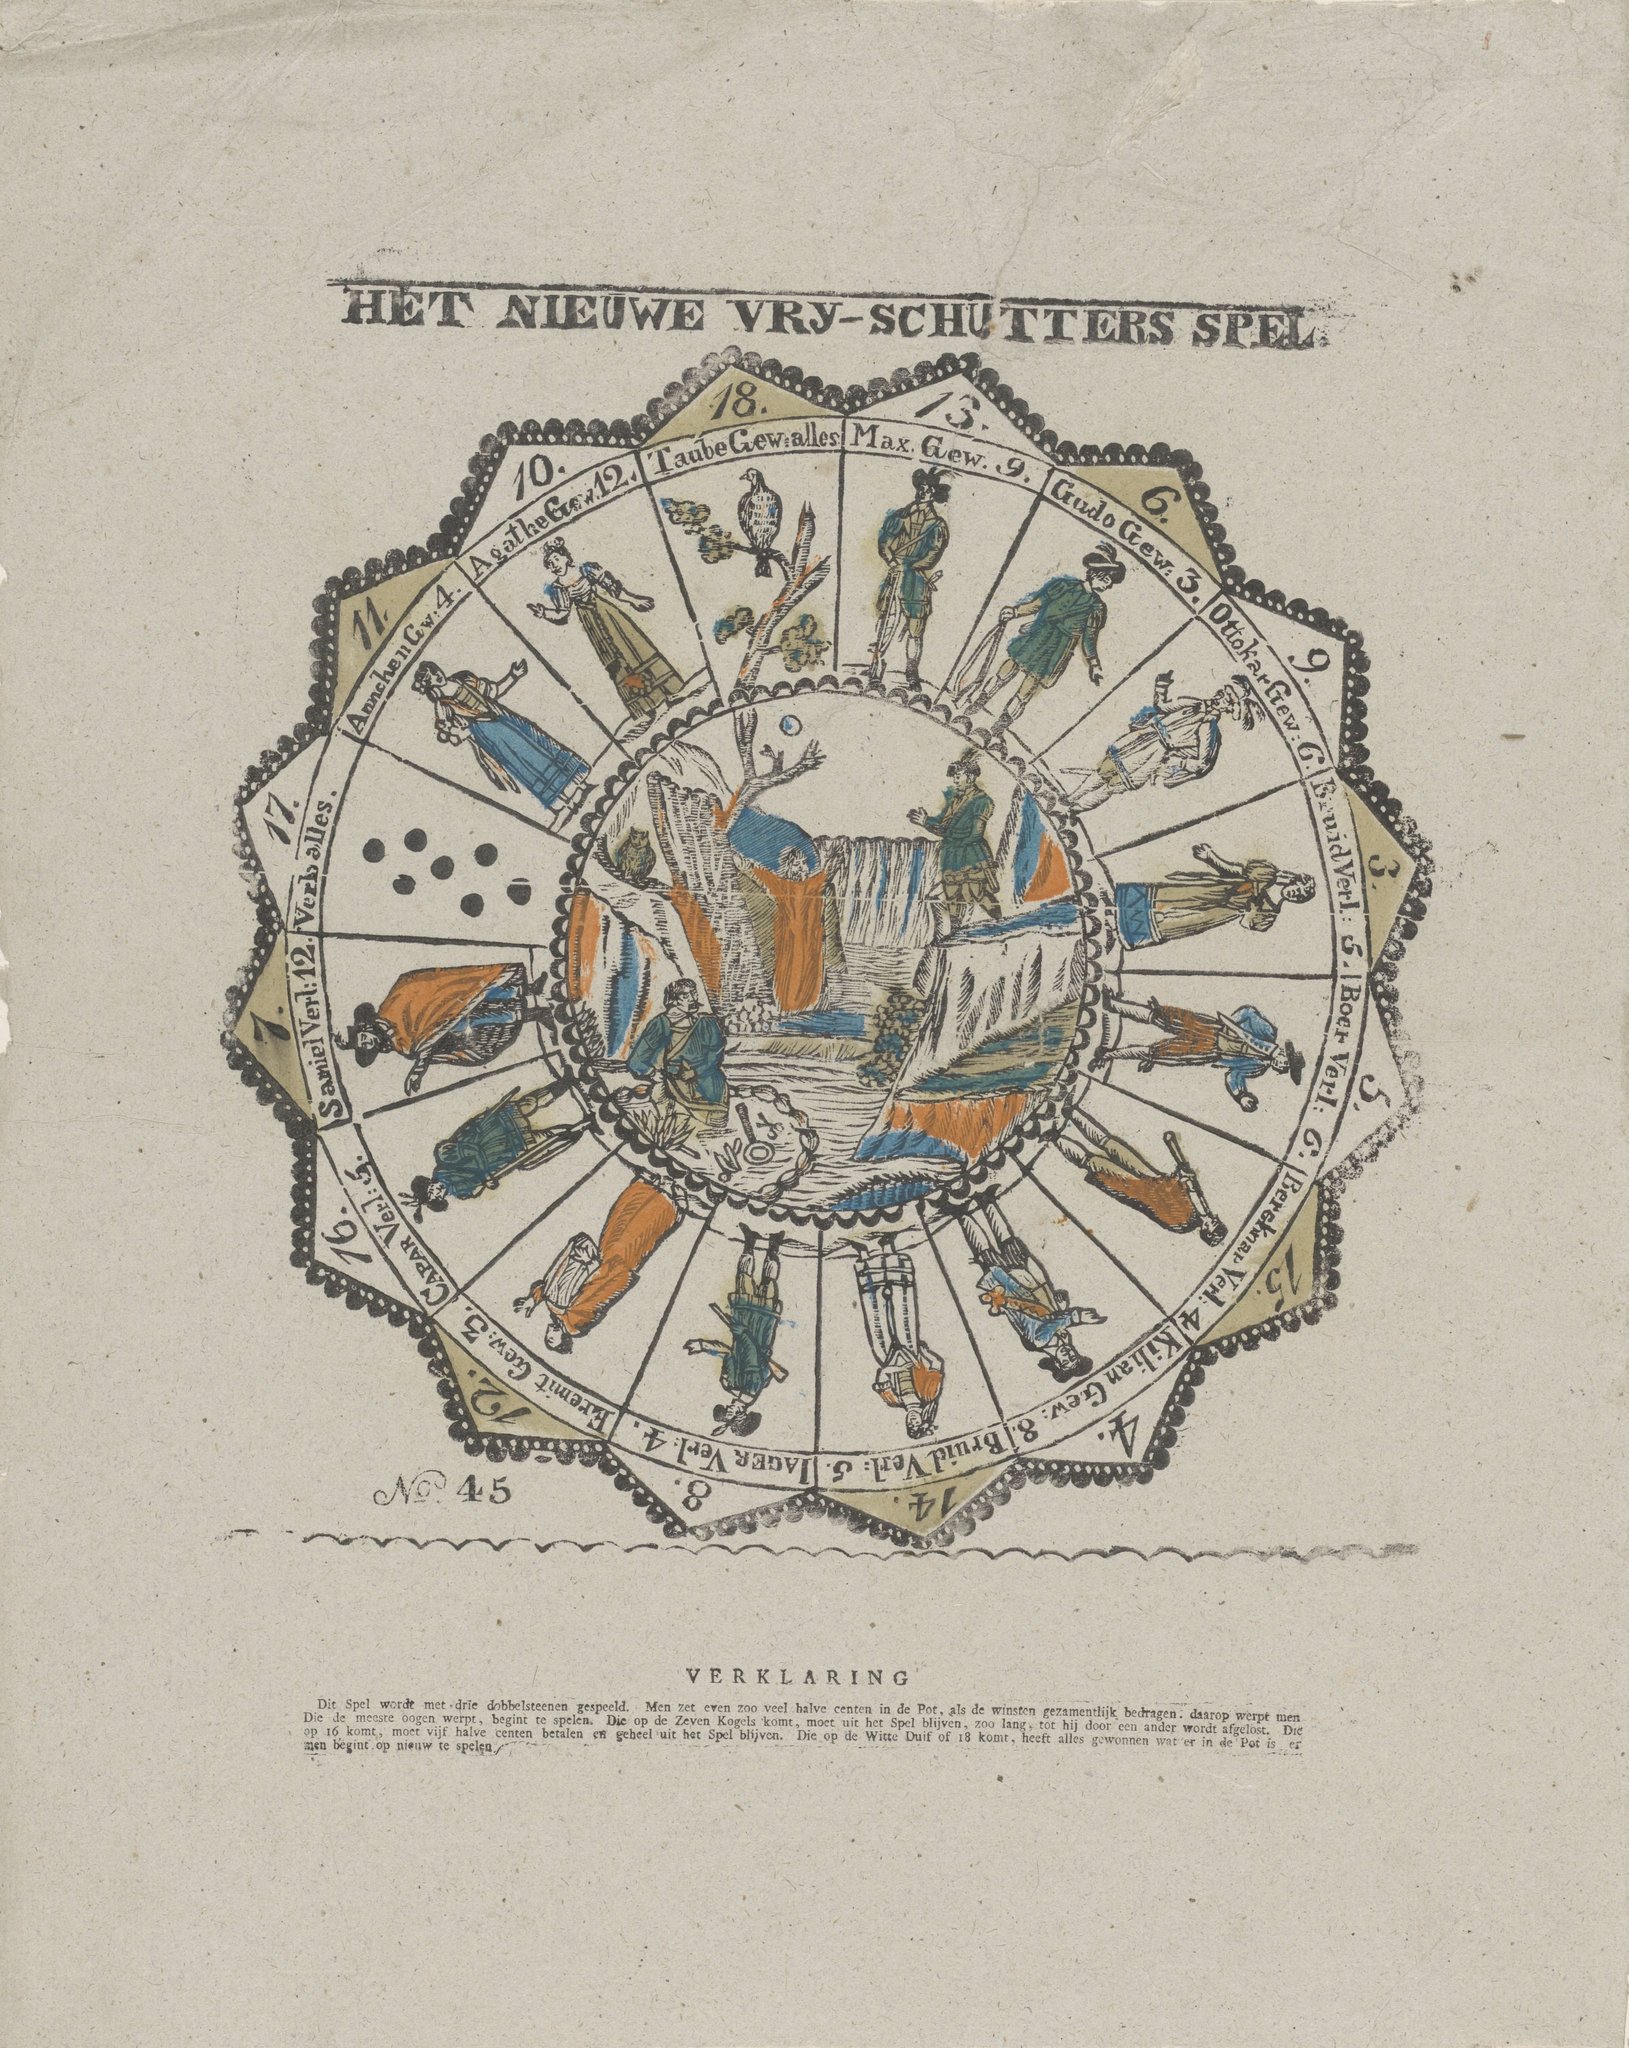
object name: popular print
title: Het nieuwe vry-schutters spel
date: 1801-1850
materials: paper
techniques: colour, letterpress printing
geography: amersfoort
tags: board-games of chance, opera, board-games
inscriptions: collector's mark: Lugt 2760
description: Bordspel gebaseerd op de opera Der Freischütz. In de verschillende vakjes van het cirkelvormige speelbord personages uit de opera. De spelregels in boekdruk midden onder. Genummerd linksonder: No. 45.